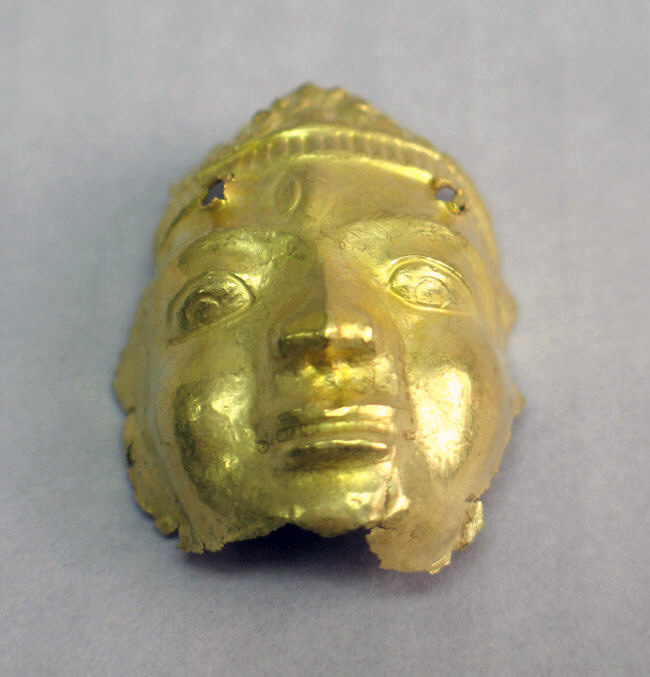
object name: head fragment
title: Head of Shiva(?)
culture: indonesian, javanese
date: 1401-1500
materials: gold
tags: heads,shiva